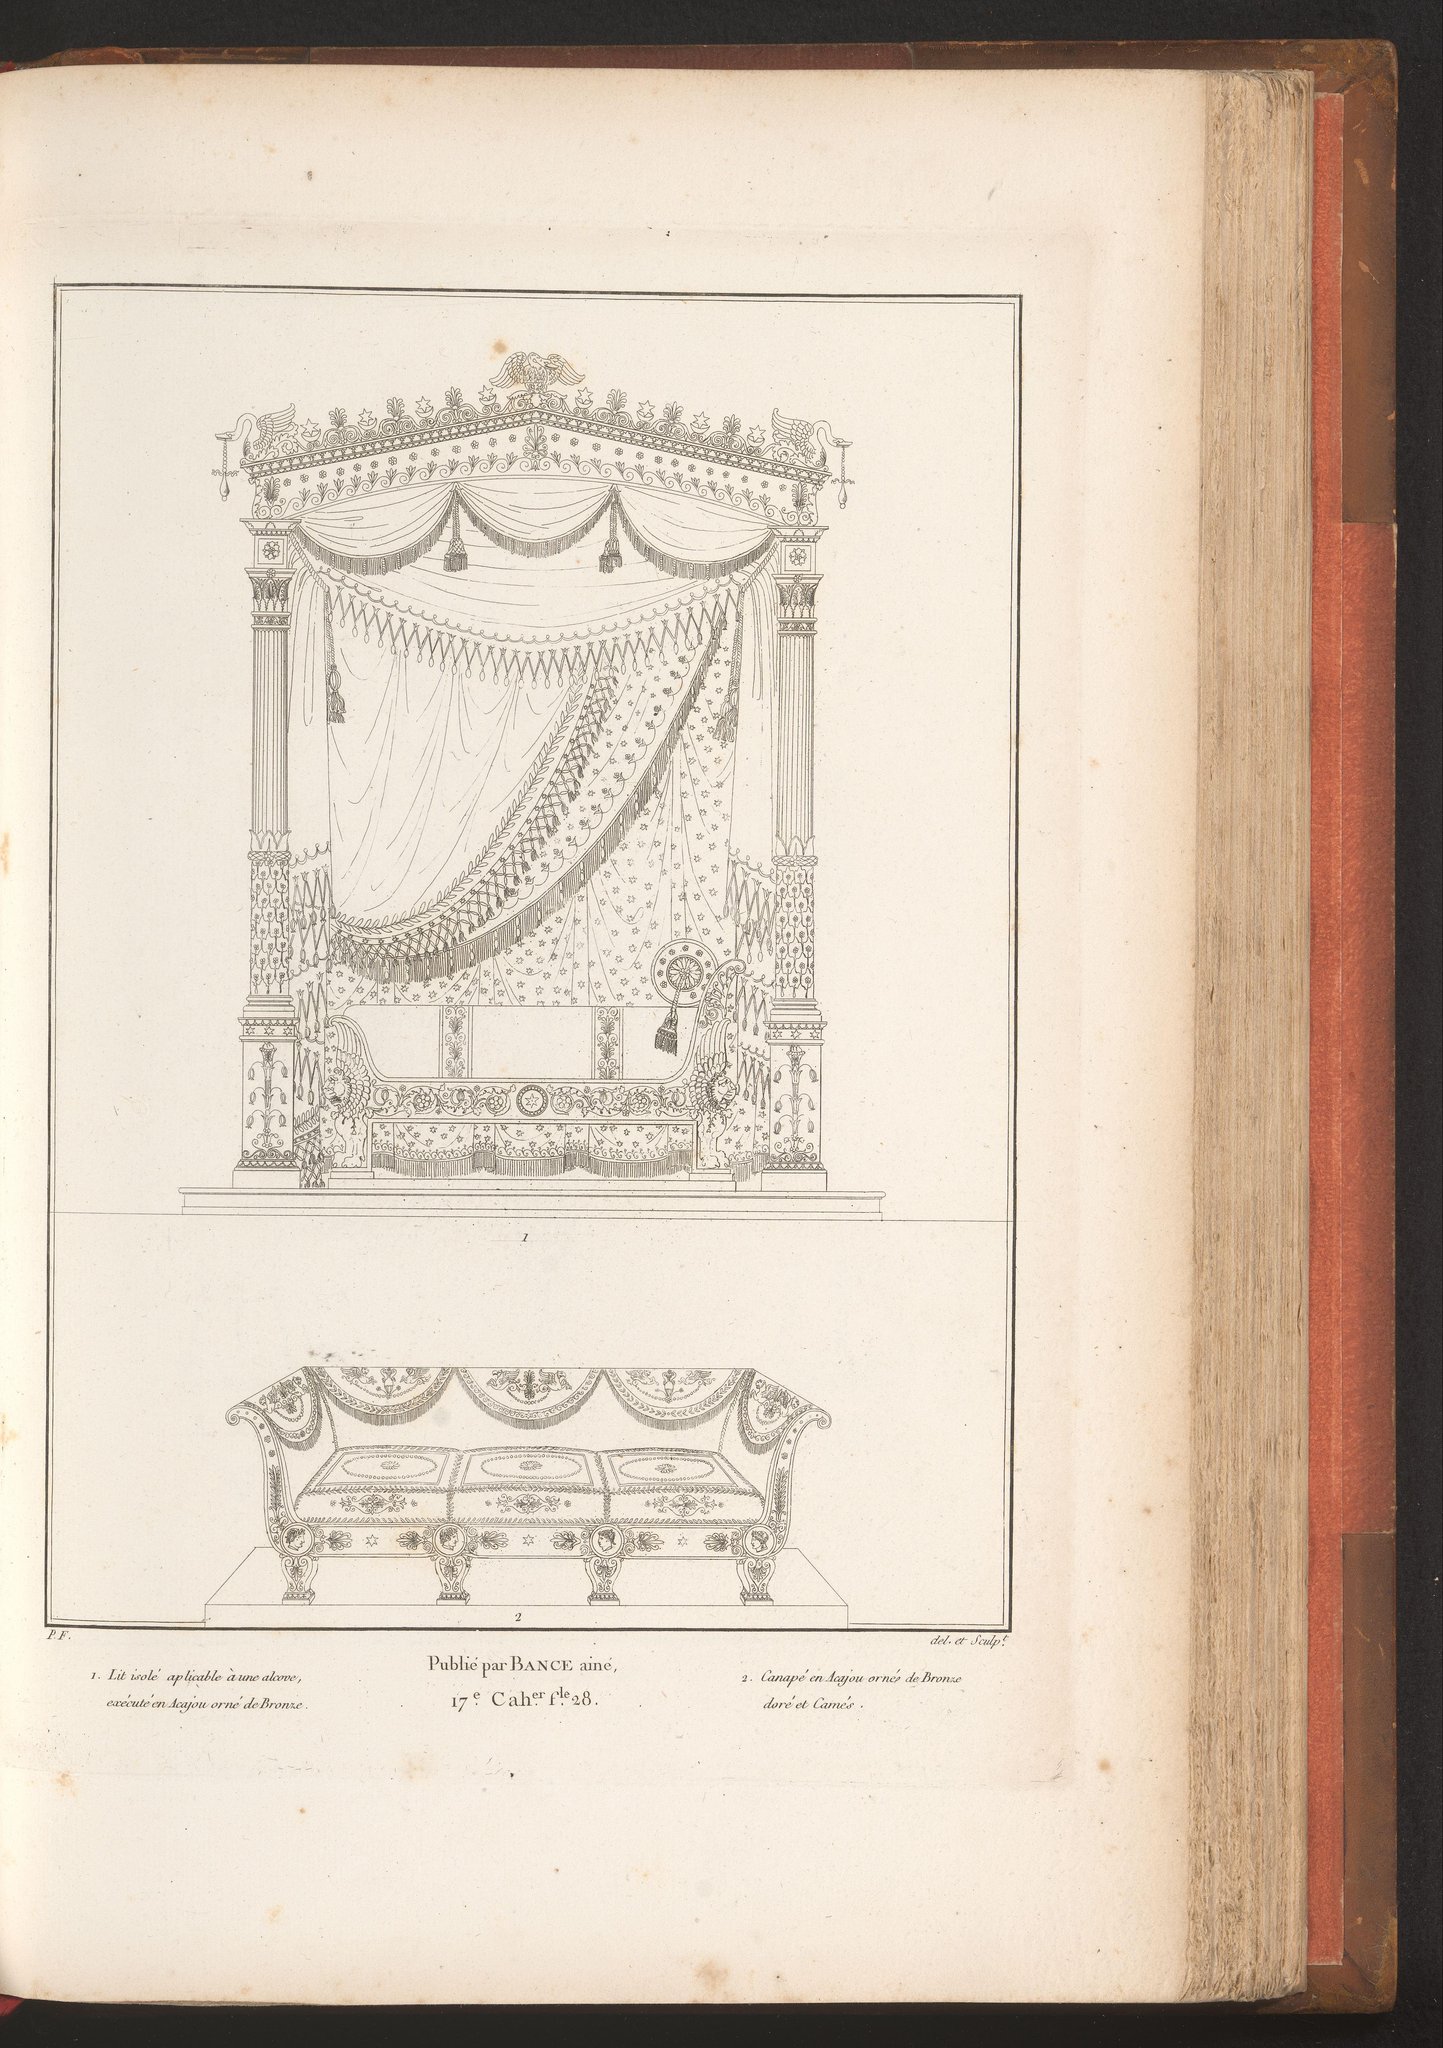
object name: ornament print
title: Twee sofa's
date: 1820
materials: paper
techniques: etching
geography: paris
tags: ornaments ~ art, couch, sofa, settee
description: Ornamentprent met twee sofa's. Onderdeel (17e. Cah.er f.le 28) van het prentalbum met twee series van in totaal 138 ornamentprenten door Beauvallet en Normand, 'Fragmens d'Ornemens dans le Style Antique'.